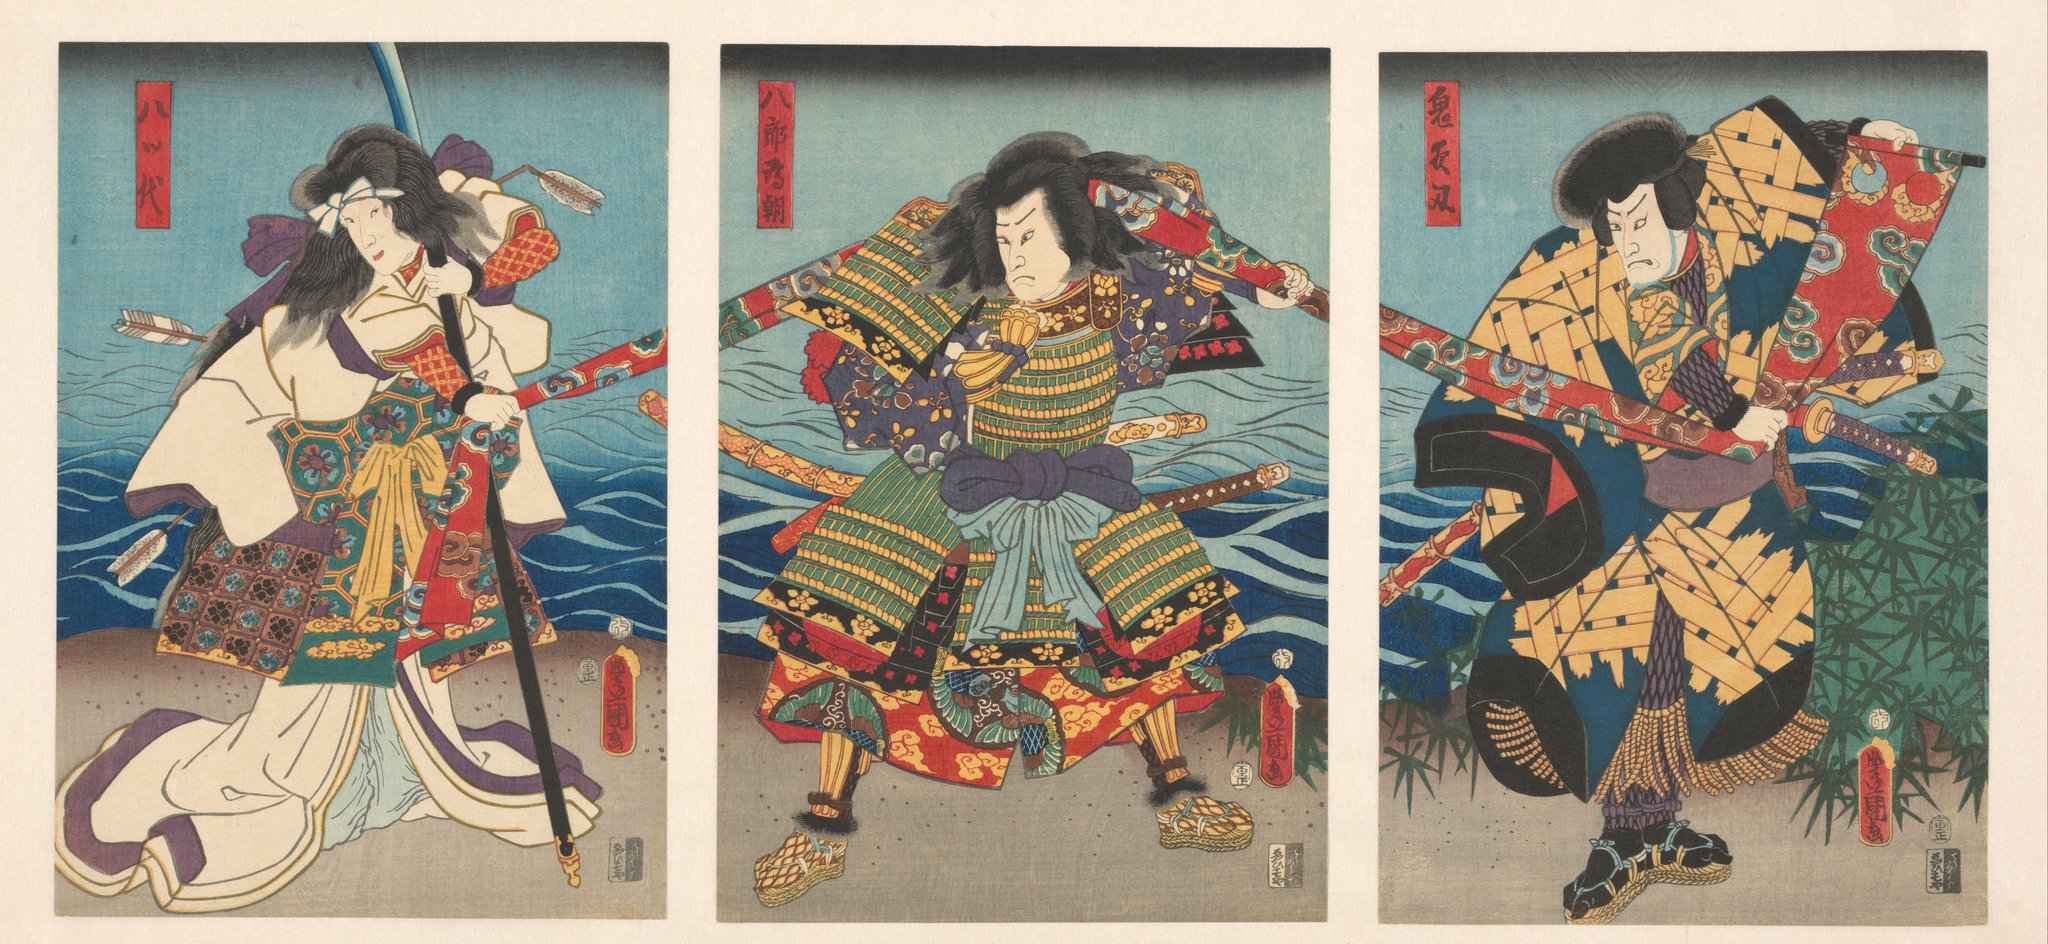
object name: print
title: Drie kabuki acteurs trekkend aan een rode banier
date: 1801-1854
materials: paper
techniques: woodcut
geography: japan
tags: tug-of-war, group of actors, troupe; actors on the stage, beach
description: Drie kabuki acteurs trekkend aan een rode banier op een strand. Links trekt de acteur Onoe Kikujirô, in de rol van de zwangere Yatsudai met hellebaard en pijlen, aan het uiteinde van een banier. In het midden staat acteur Kataoka Gadô II in de rol van de beroemde boogschutter Hachirô Tametomo, in harnas, met de banier over zijn schouders. Rechts de boosaardige Yasha gespeeld door Bandô Hikusaburô IV. Op de achtergrond de zee.